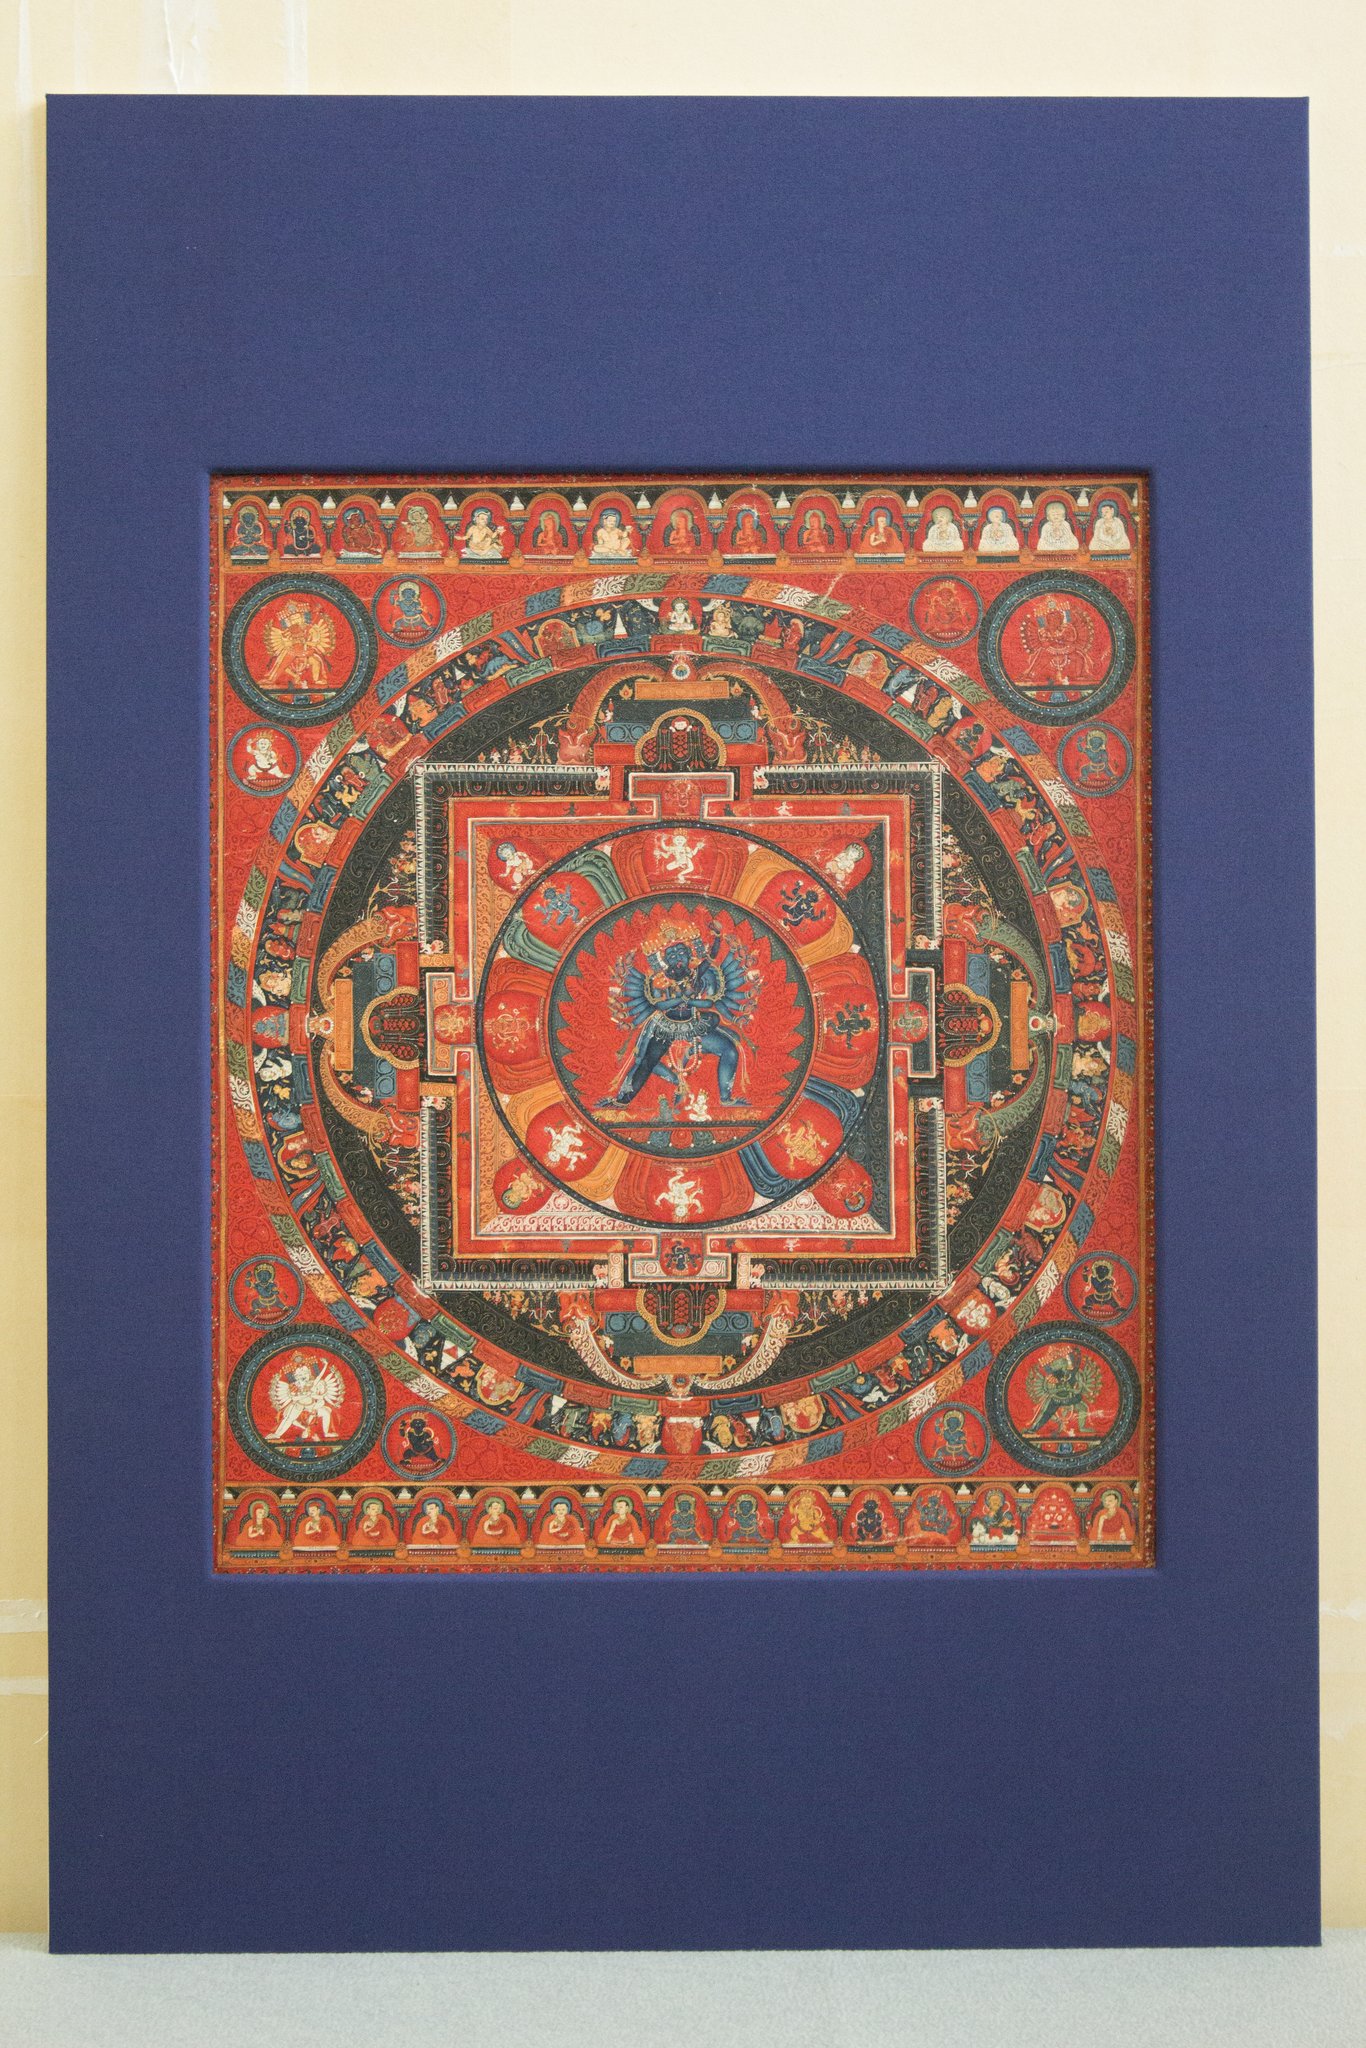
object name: painting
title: Mandala of Hevajra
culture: tibetan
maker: sakya school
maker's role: artist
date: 1501-1600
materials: textile, ink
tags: buddhism,deities